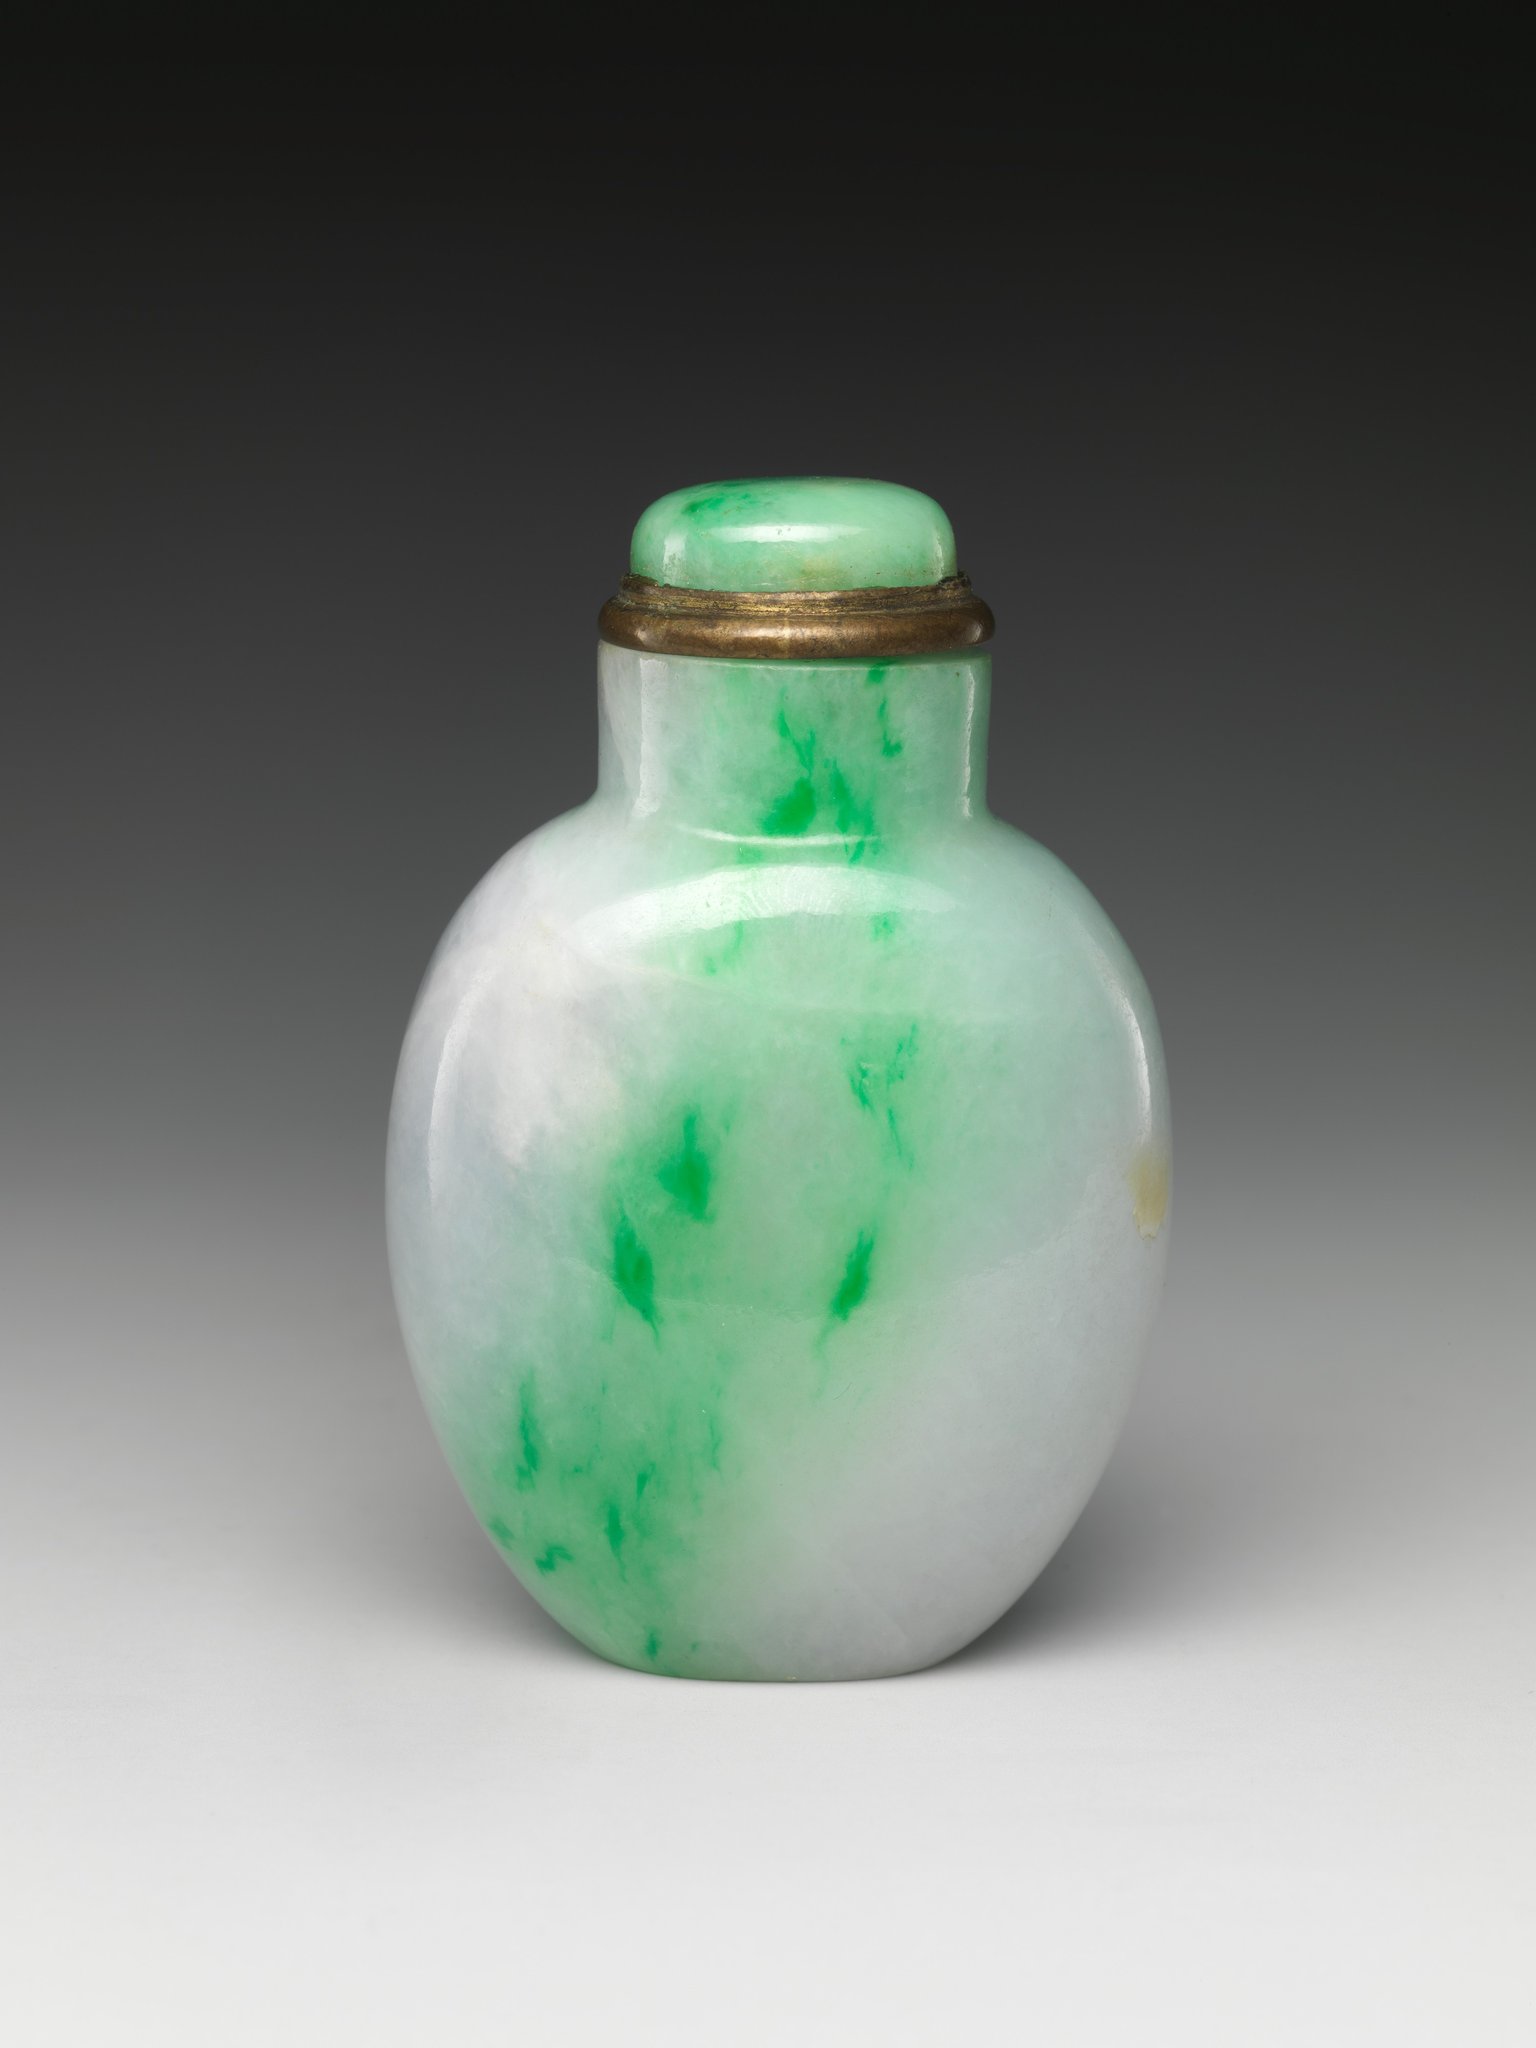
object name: snuff bottle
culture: chinese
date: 1801-1900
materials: jade